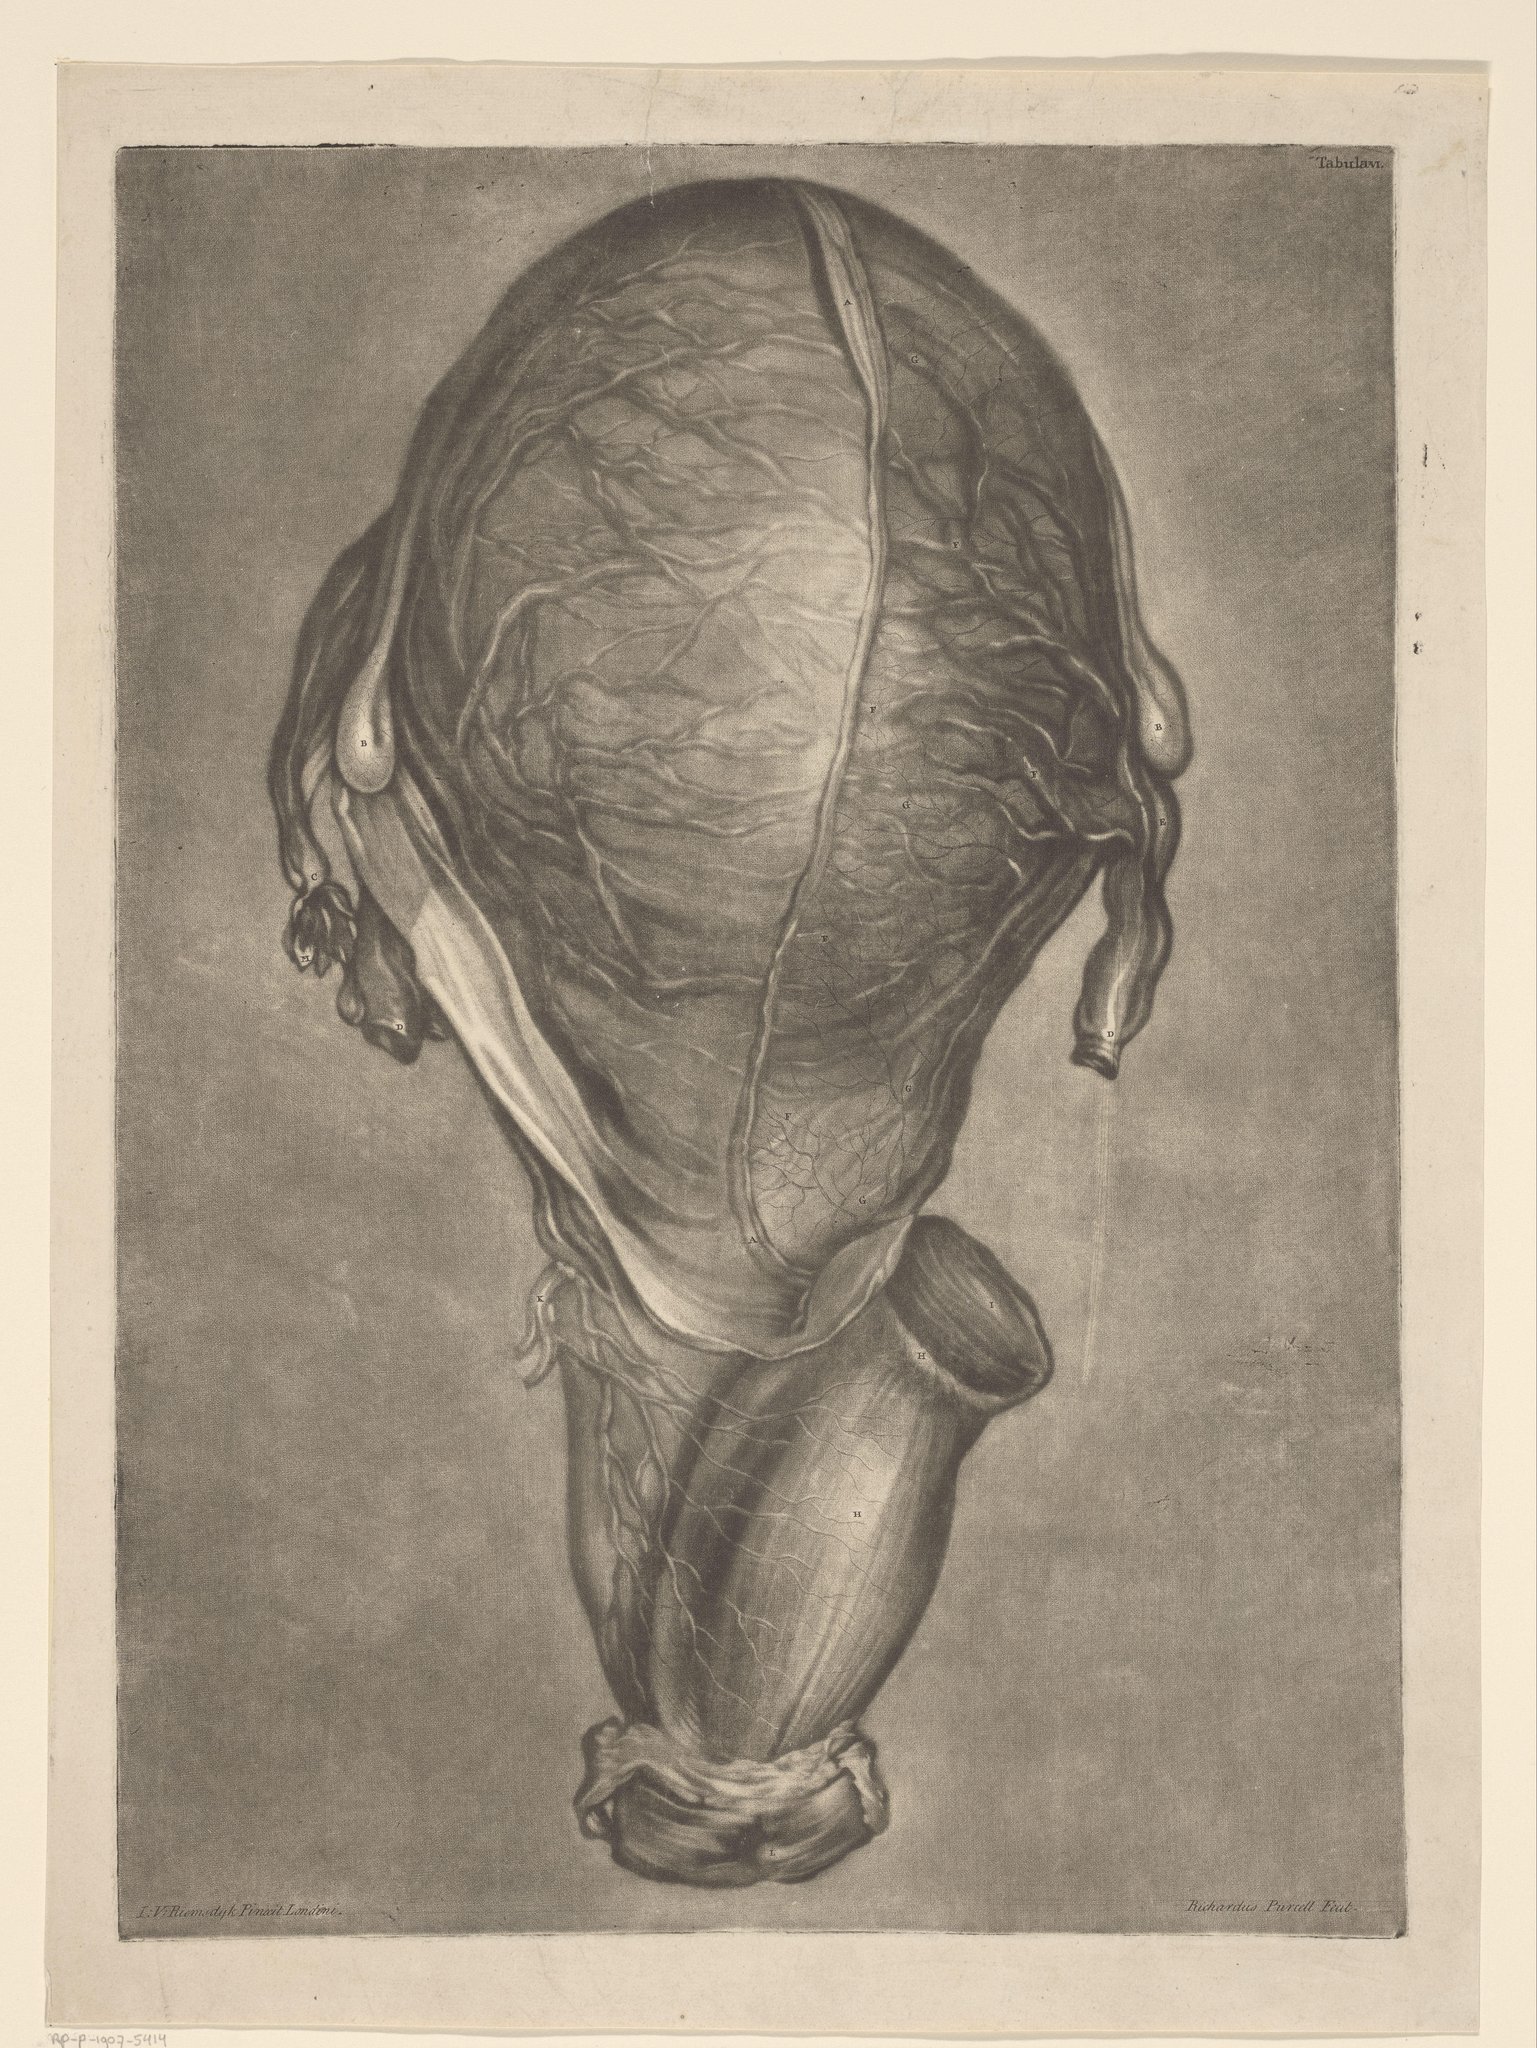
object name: print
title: Zes anatomische prenten van een zwangerschap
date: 1757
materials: paper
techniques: etching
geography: london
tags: physiology and anatomy, womb, uterus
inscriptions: collector's mark: Lugt 2228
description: De volledige titel van de serie luidt 'The demonstrations of a pregnant uterus of a woman at her full time. In six tables, as large as nature. Done from the pictures painted, after dissections, by Mr. van Riemsdyk' en verscheen voor het eerst in Londen in 1757 op initiatief van professor in de anatomie en chirurgie Charles Nicholas Jenty.